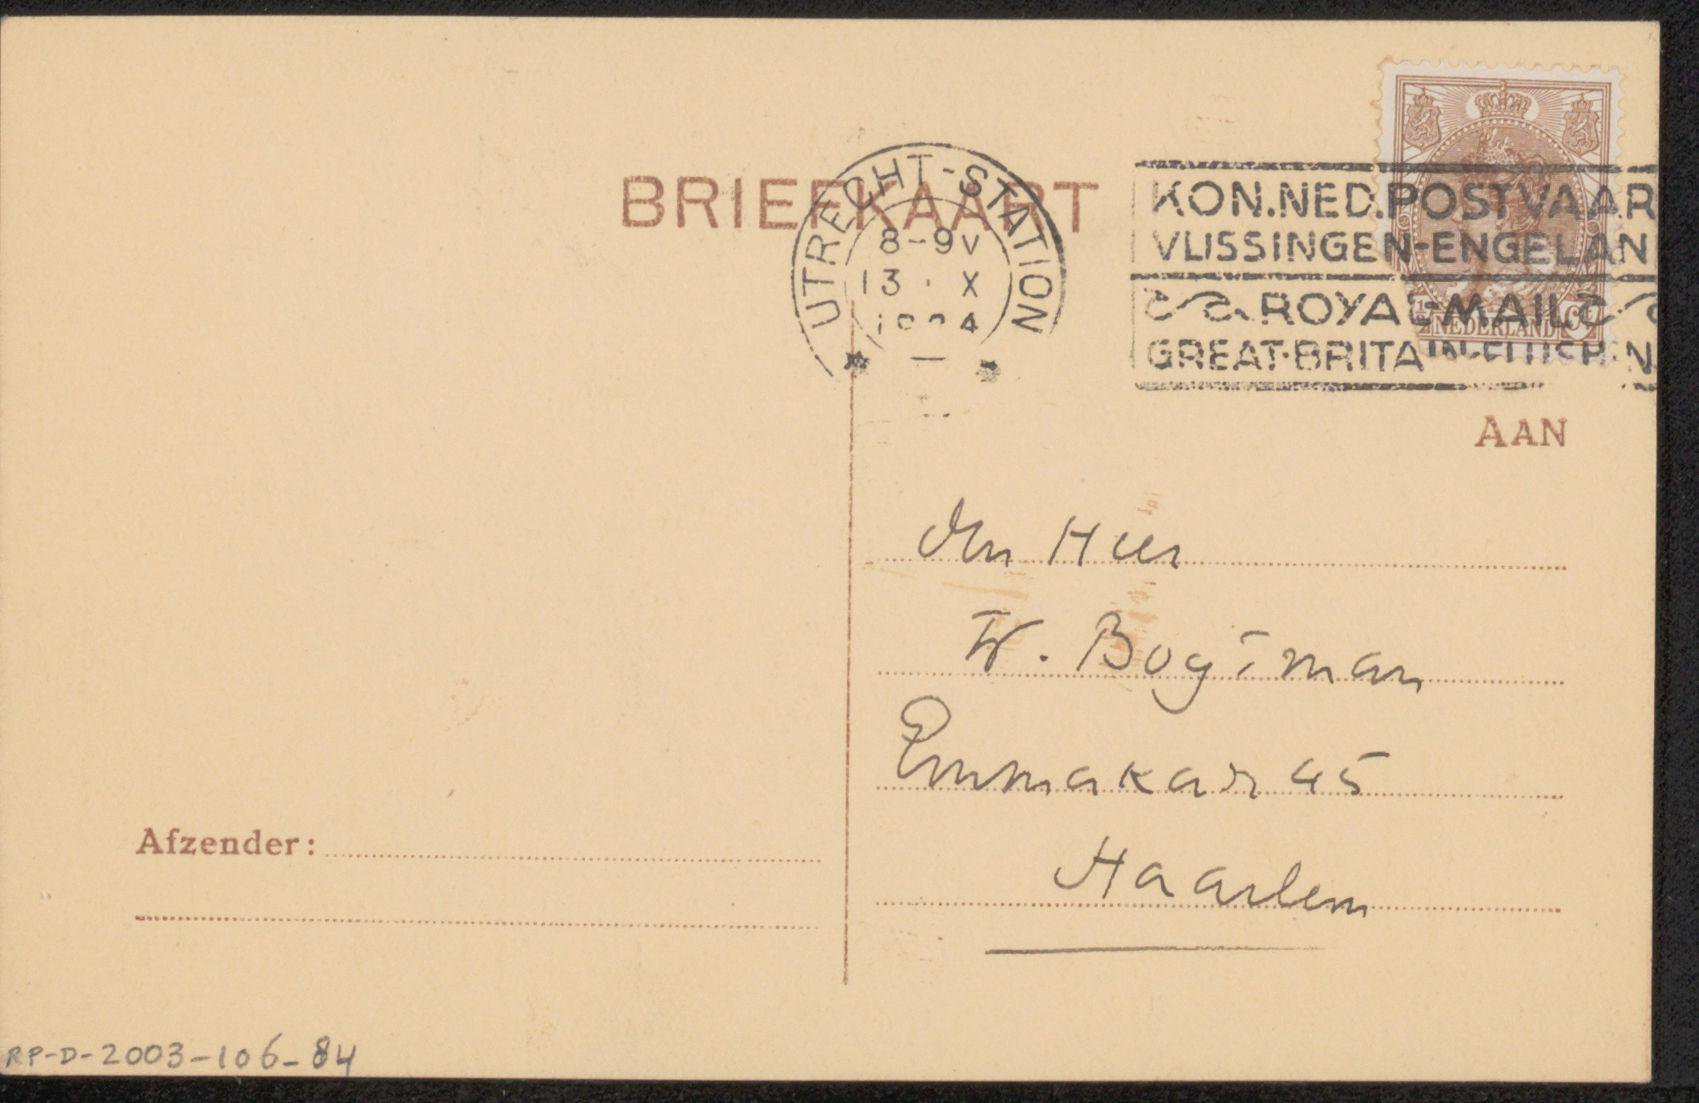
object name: postcard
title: Briefkaart aan Willem Bogtman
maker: richard nicolaüs roland holst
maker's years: 1868-1938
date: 1924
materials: cardboard, ink, pencil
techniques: pen, writing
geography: utrecht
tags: haarlem, willem bogtman, henriëtte roland holst-van der schalk